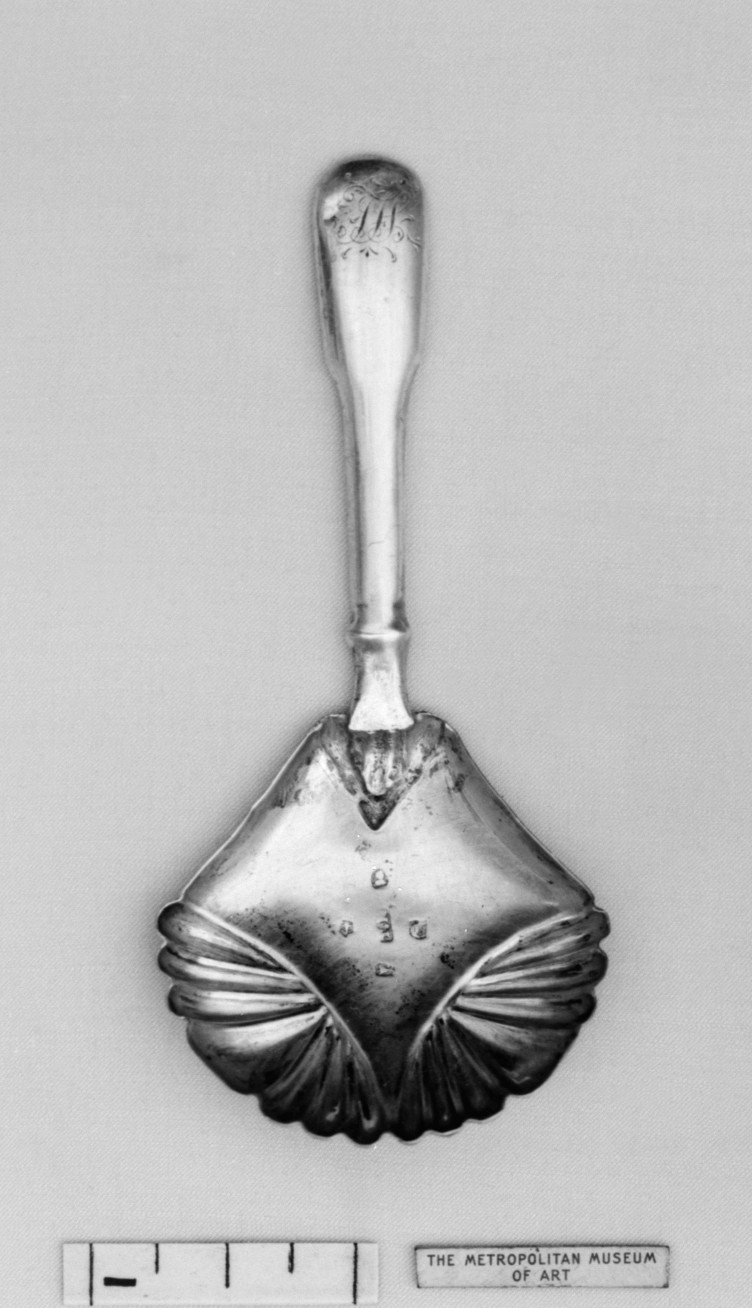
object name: caddy spoon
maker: thos. newbold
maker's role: maker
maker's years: 1820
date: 1826-1827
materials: silver